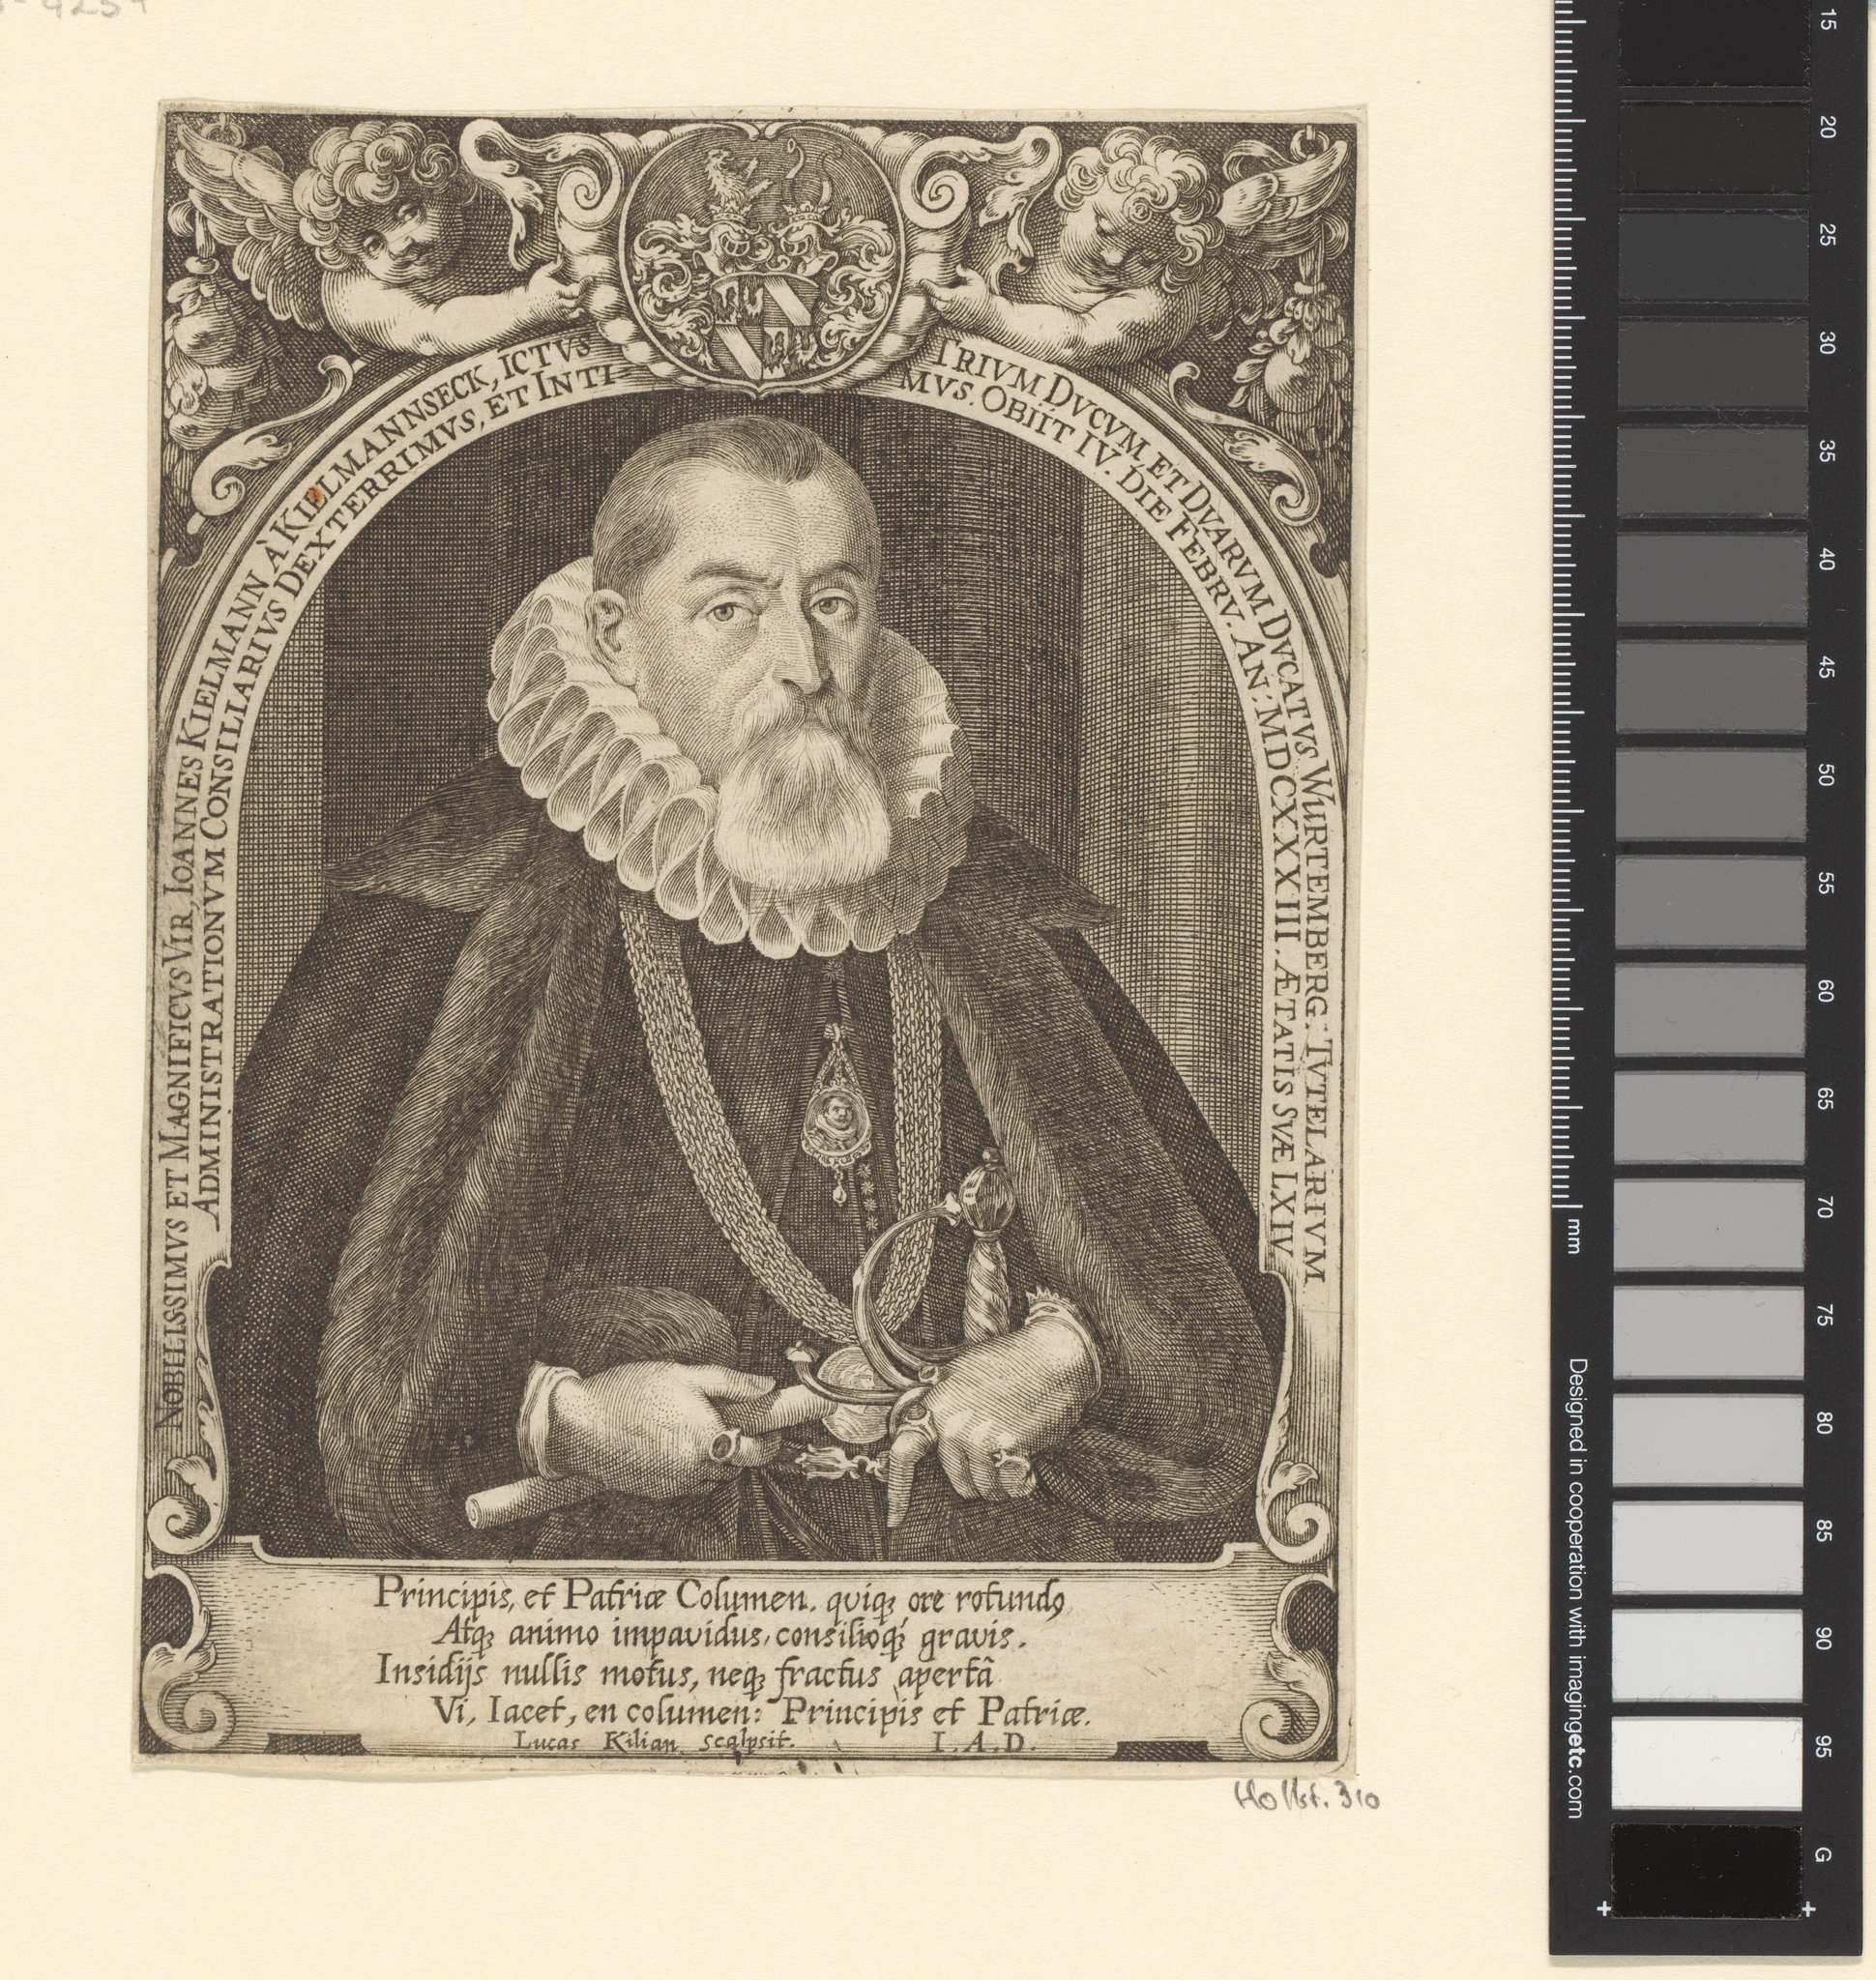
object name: print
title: Portret van Justus von Gebhard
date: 1637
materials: paper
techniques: engraving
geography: augsburg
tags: vienna, historical persons, lawyer, attorney at law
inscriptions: collector's mark: Lugt 2228